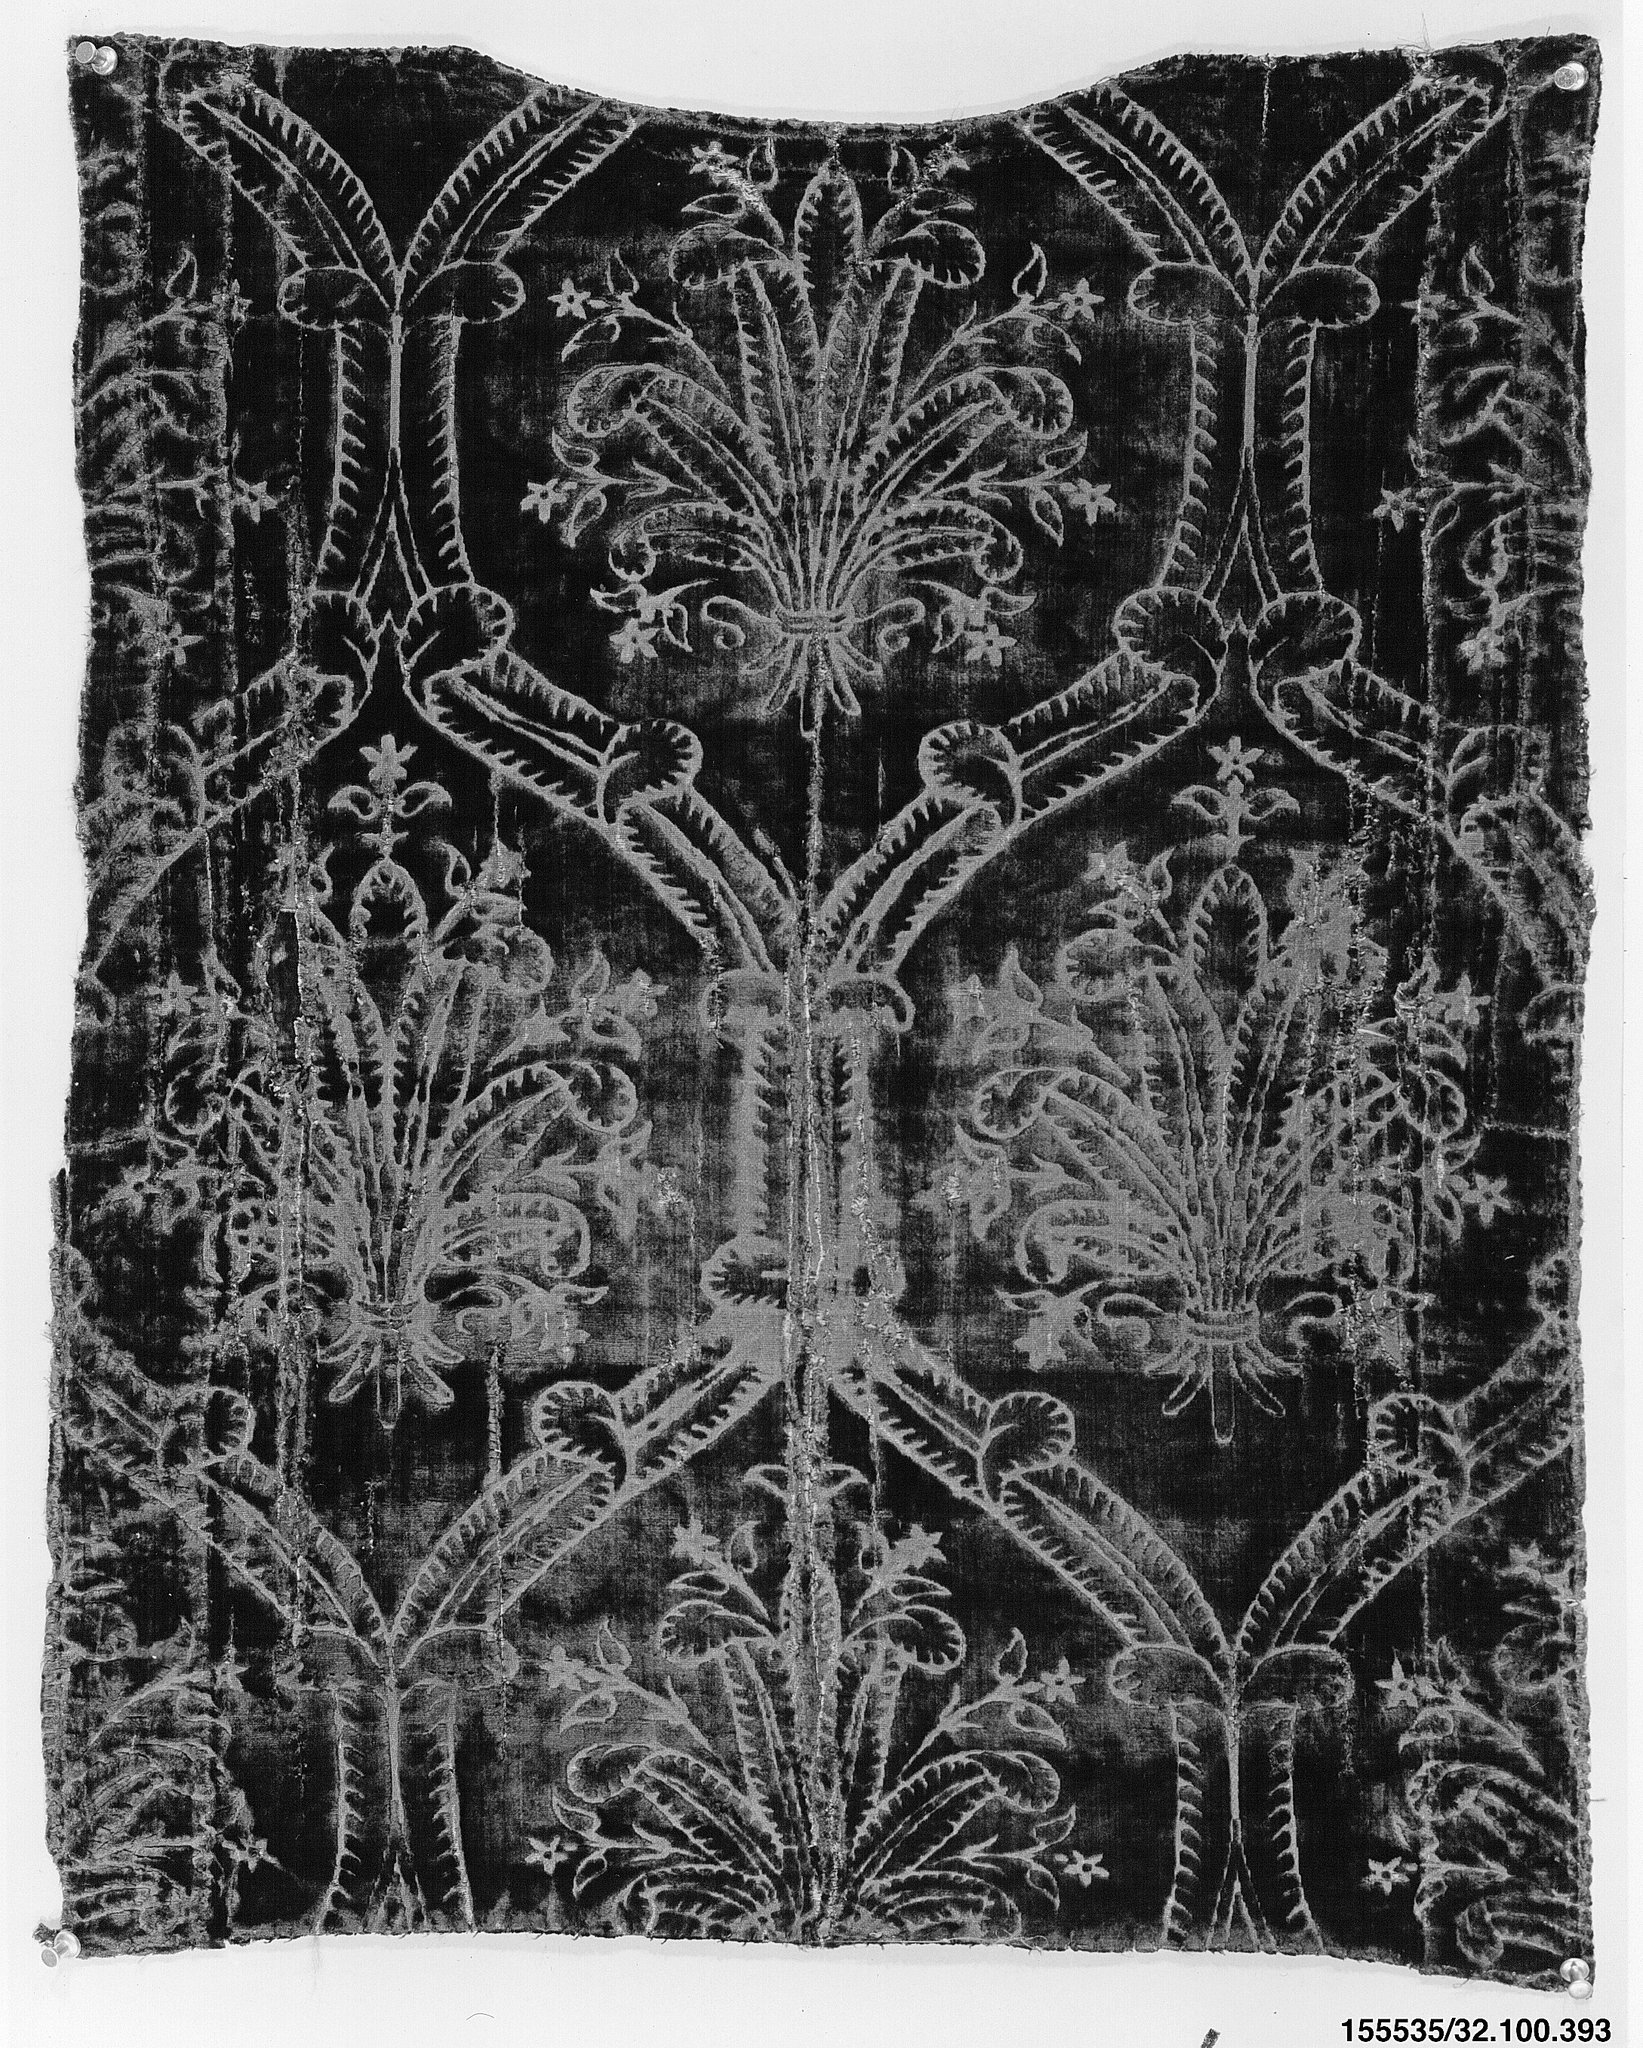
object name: piece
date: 1501-1600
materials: silk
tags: flowers